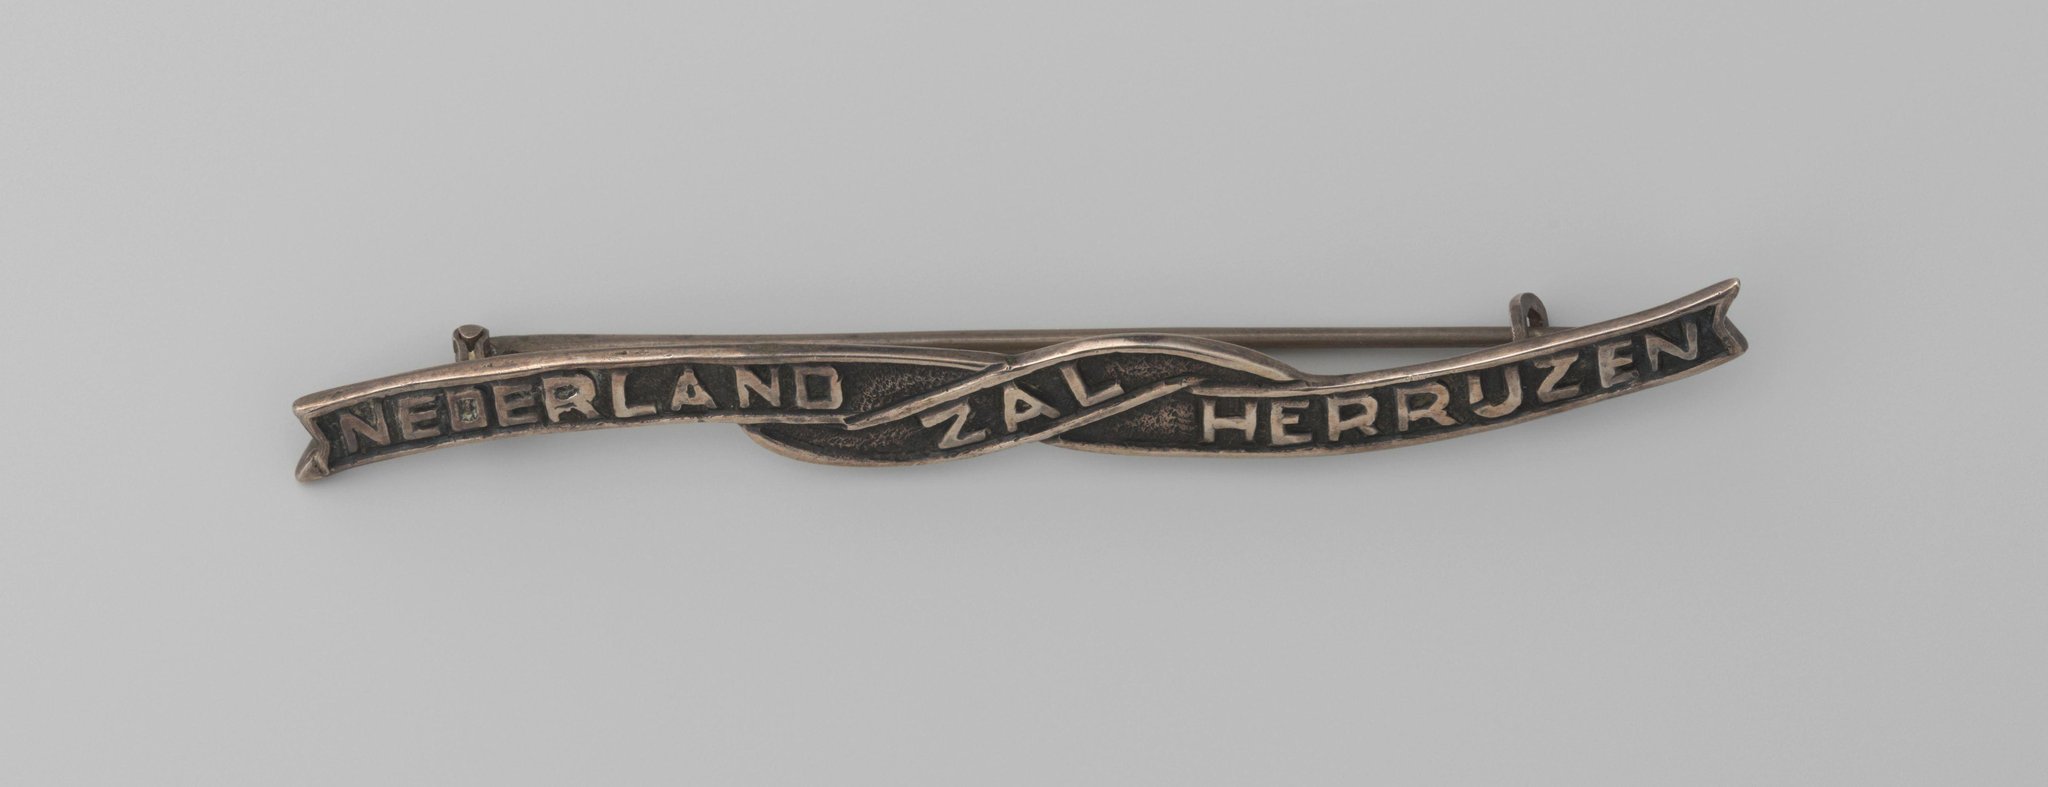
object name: brooch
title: Broche 'Nederland zal herrijzen'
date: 1940-1945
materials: silver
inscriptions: inscription: ‘Nederland zal herrijzen’, : ‘RS800’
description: Broche in de vorm van een banderol met daarop de tekst 'Nederland zal herrijzen' van zilver met een laag gehalte, voorzien van een haaksluiting.